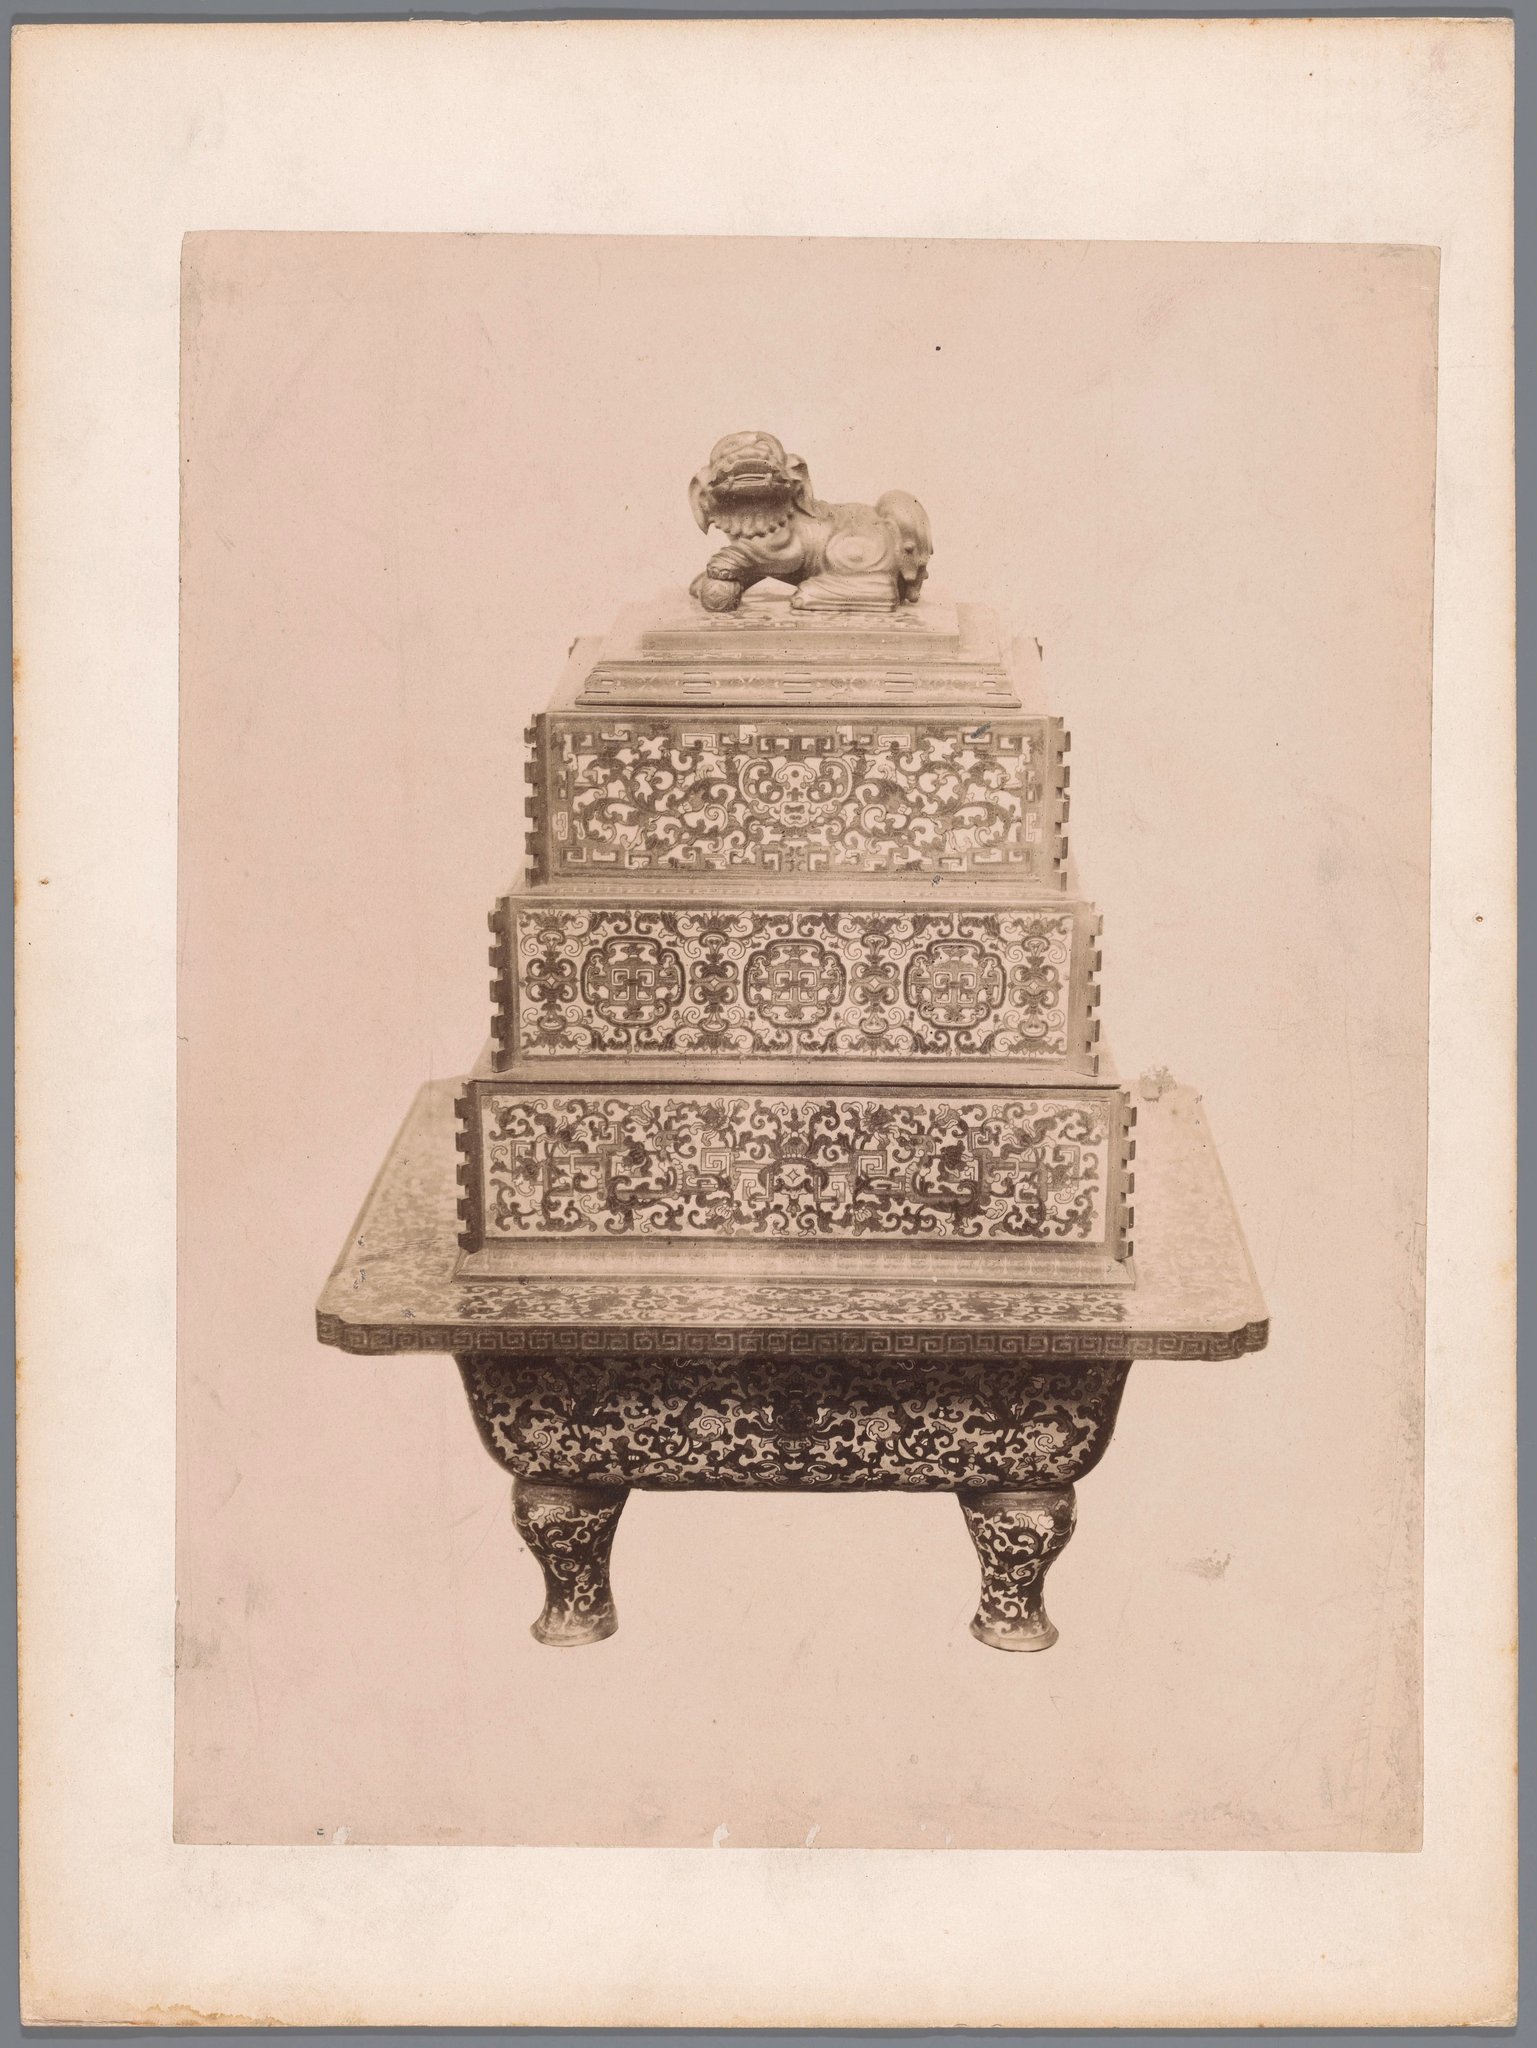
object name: photograph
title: Pot met een trapsgewijze gevormde deksel gedecoreerd met Aziatische motieven, een plantmotief en een leeuw op de deksel, mogelijk een tabakspot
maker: Anonymous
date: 1875-1900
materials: cardboard, photographic support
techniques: albumen print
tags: container of ceramics: jar, jug, pot, vase, beasts of prey, predatory animals: lion, ornament derived from plant forms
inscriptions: collector's mark: Lugt 3937